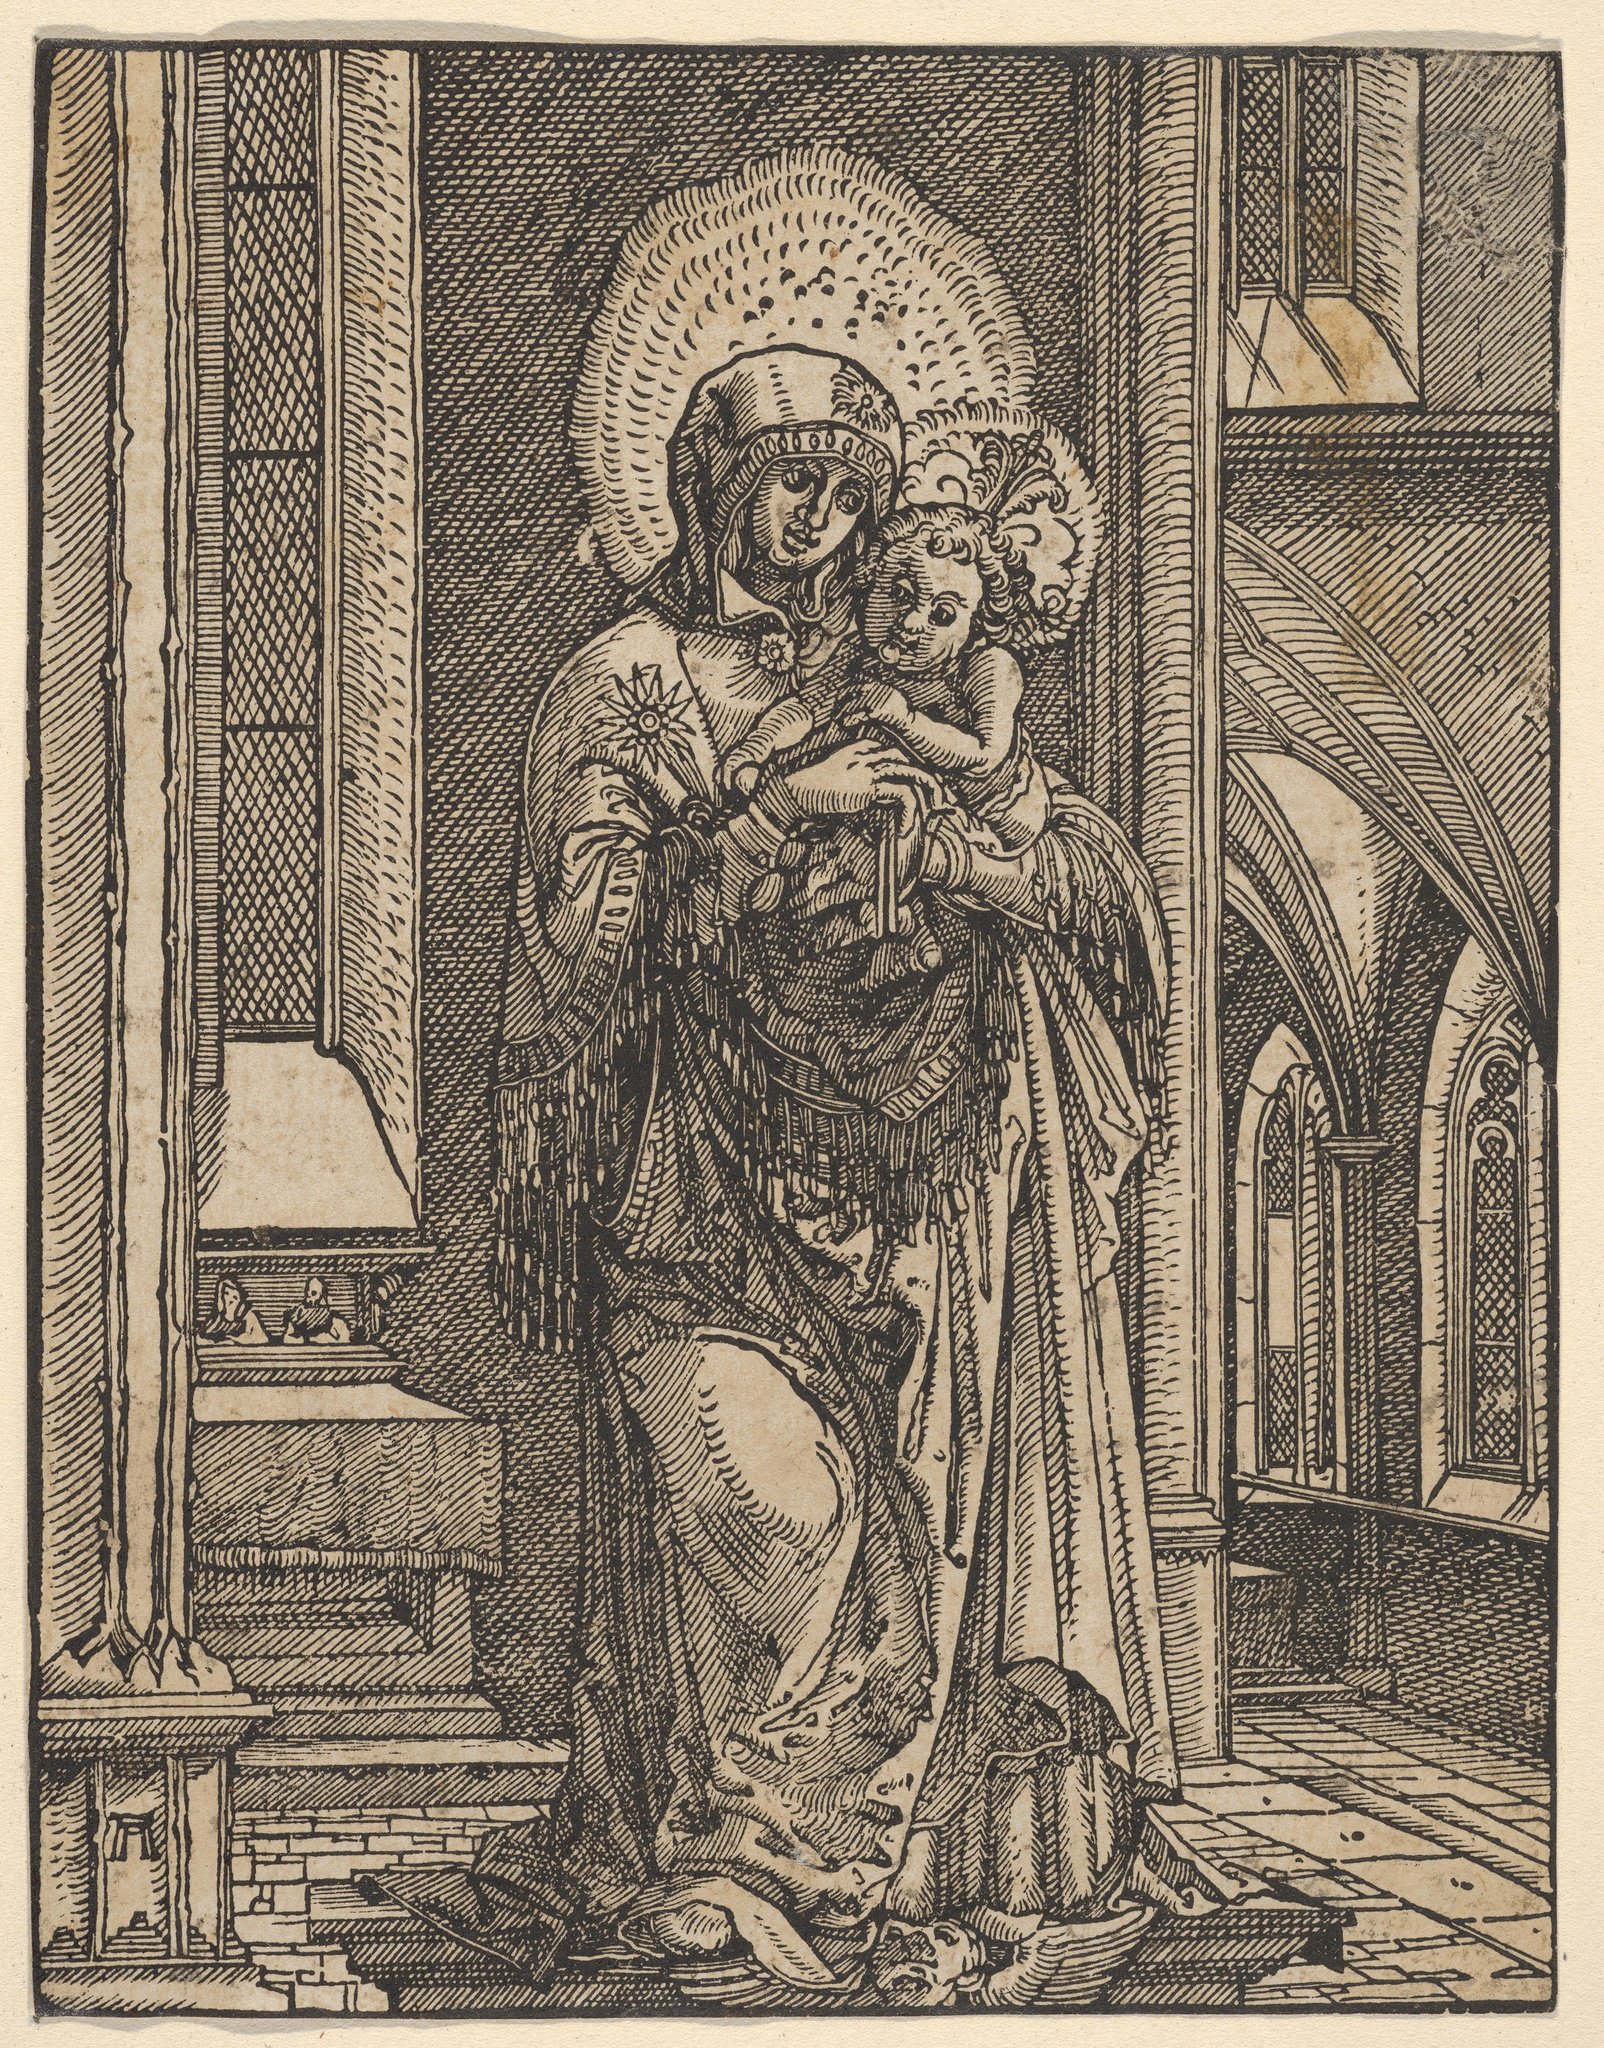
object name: print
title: The Beautiful Virgin of Regensburg in a Church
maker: albrecht altdorfer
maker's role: artist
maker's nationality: german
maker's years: 1480-1538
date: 1500-1538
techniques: woodcut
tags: churches,madonna and child